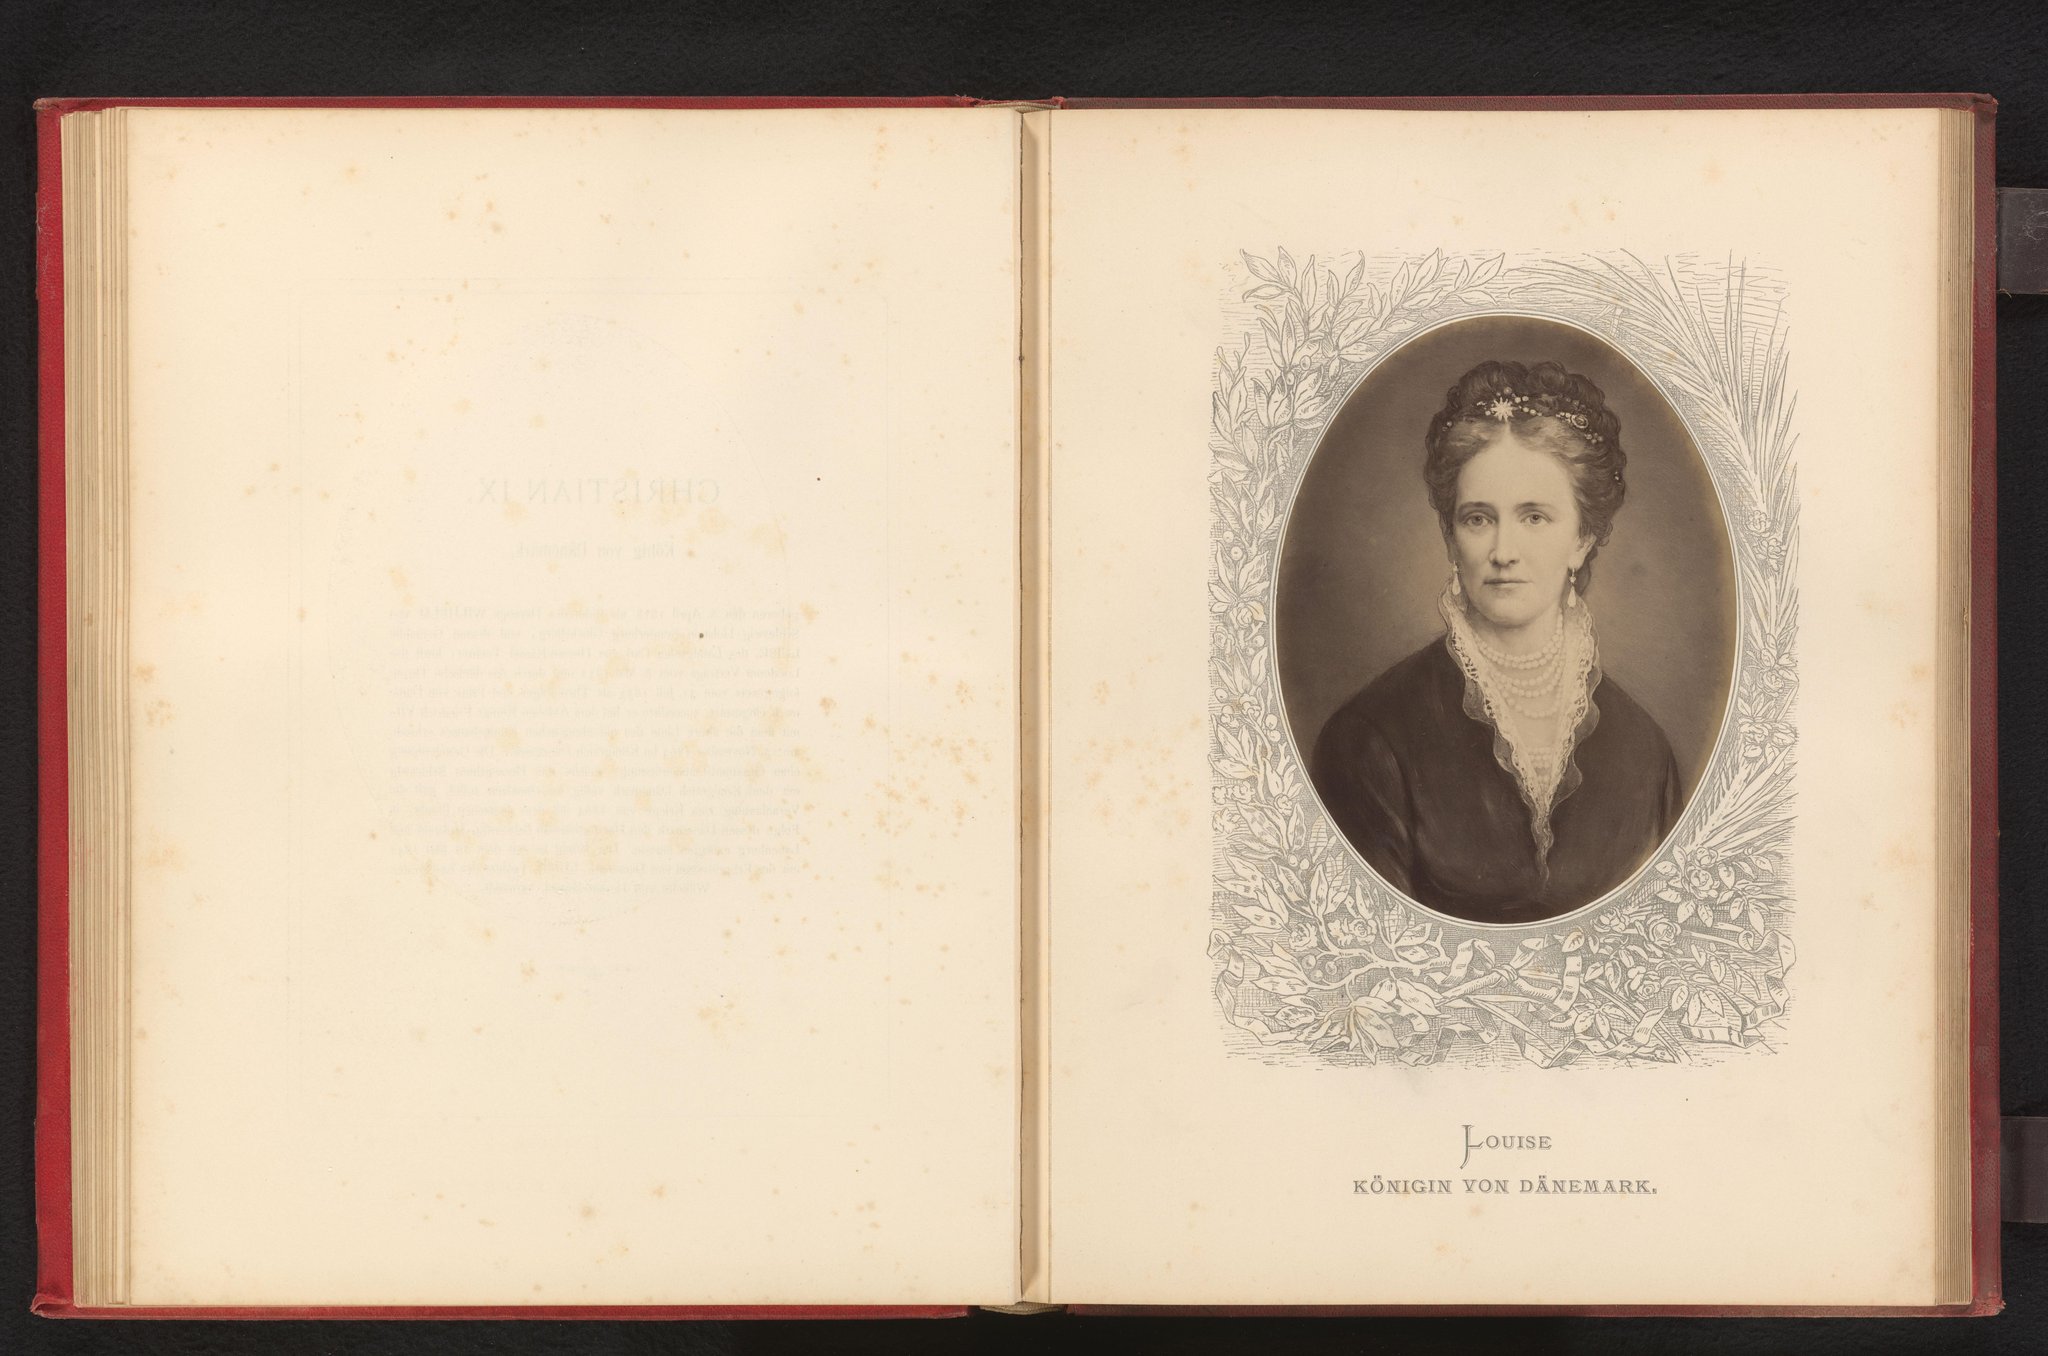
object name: reproduction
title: Louise, Königin von Dänemark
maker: Anonymous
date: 1875-1880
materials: paper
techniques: albumen print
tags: historical persons - bb - woman, queen, empress, etc. (wife of a ruler)